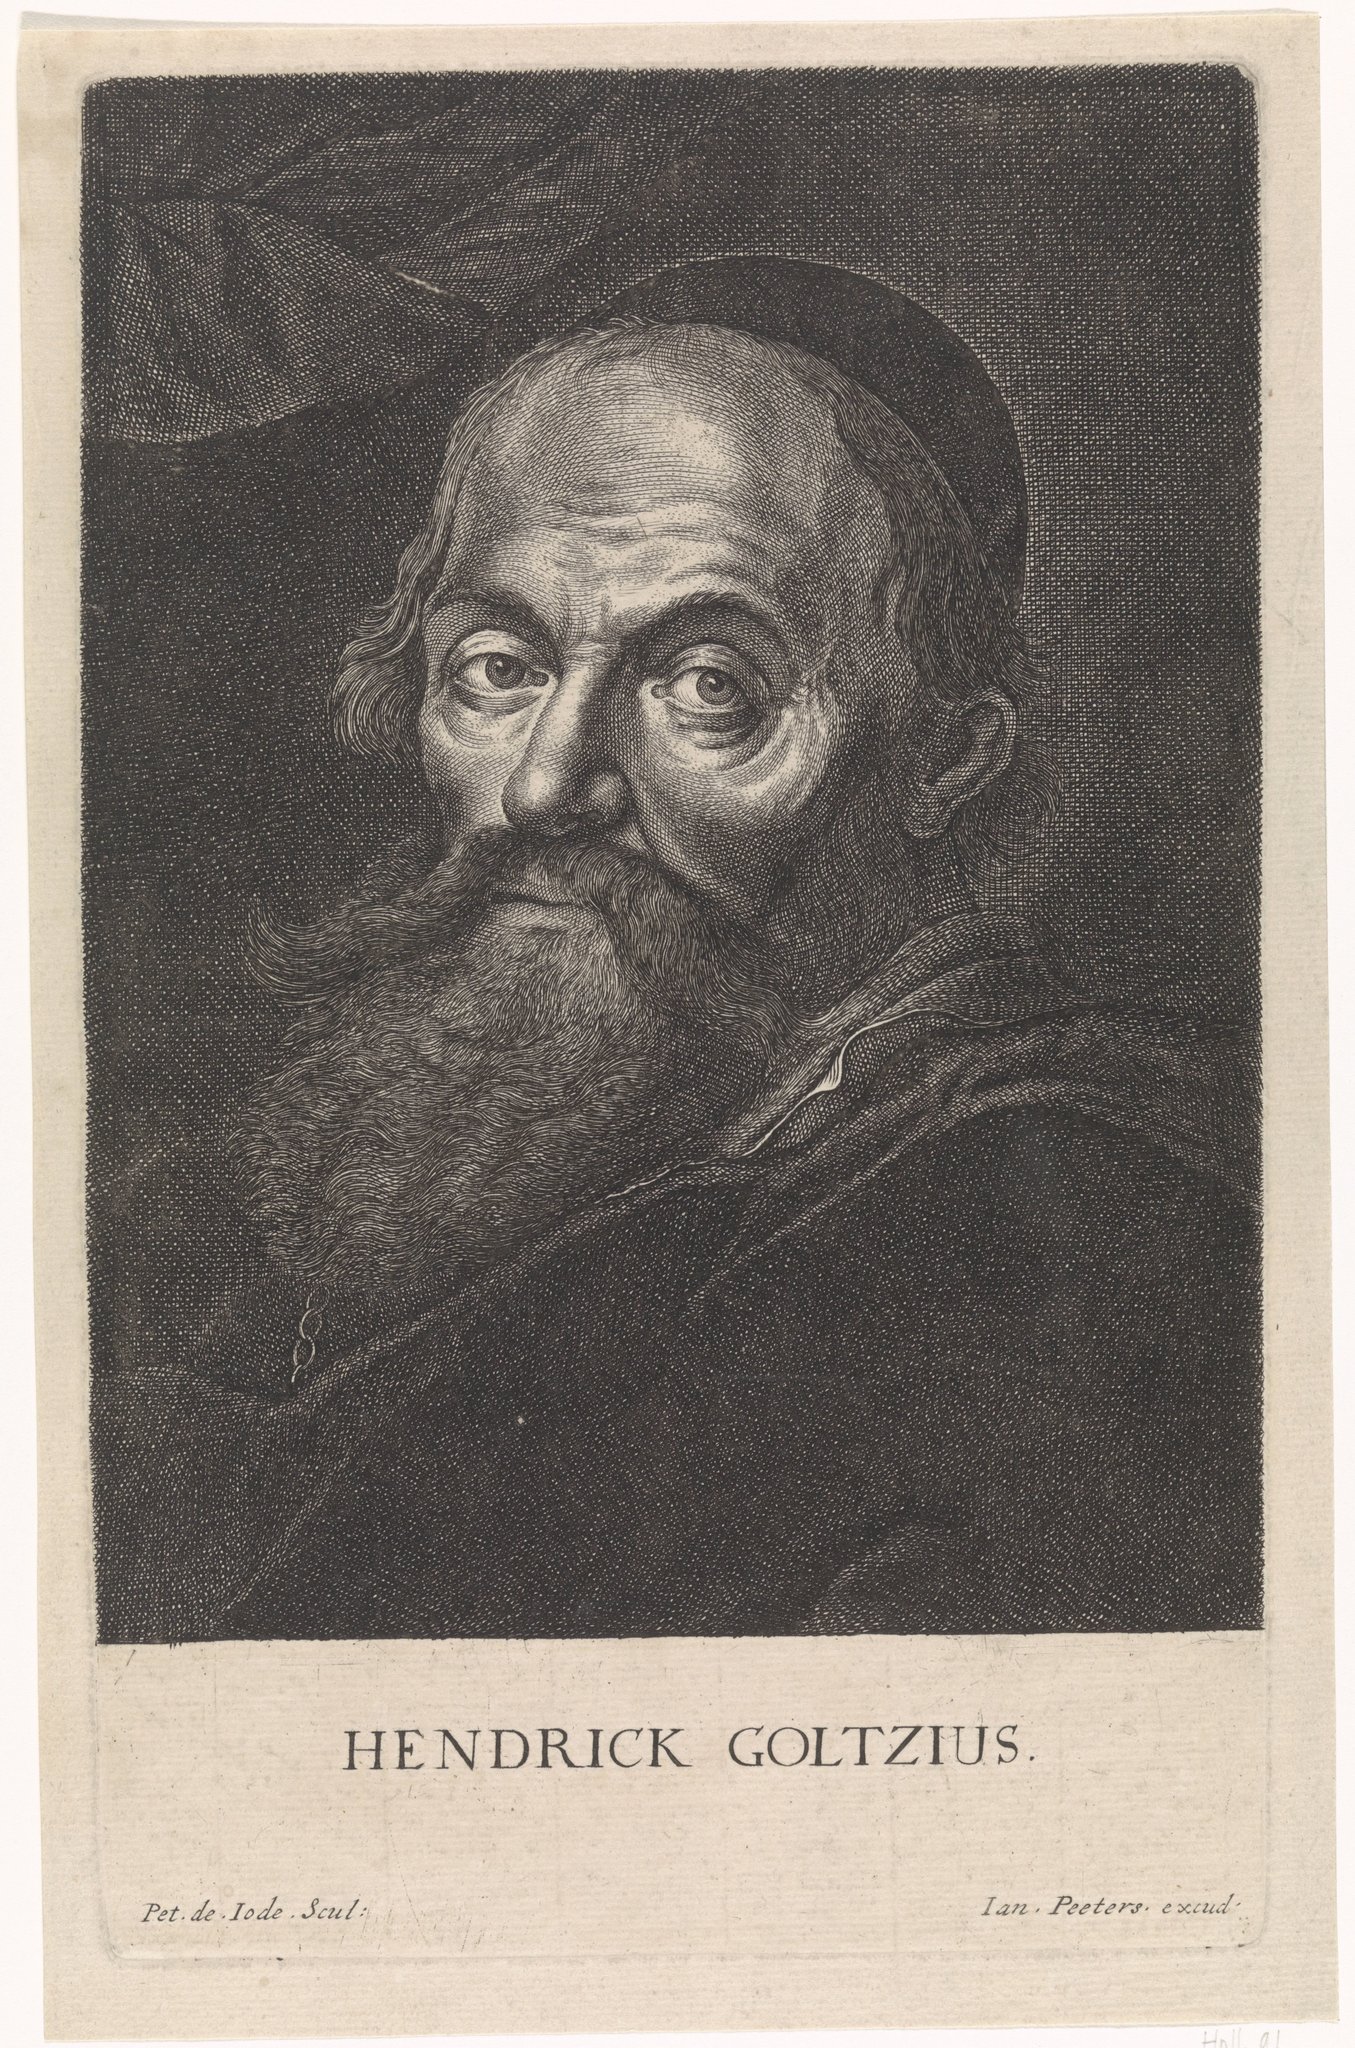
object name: print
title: Portret van Hendrick Goltzius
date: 1628-1670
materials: paper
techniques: engraving, etching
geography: antwerp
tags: plateelbakkerij, de witte ster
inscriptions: collector's mark: Lugt 2233, collector's mark: Lugt 654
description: Busteportret van de kunstenaar Hendrick Goltzius, met kalot. In de marge de naam van de geportretteerde.